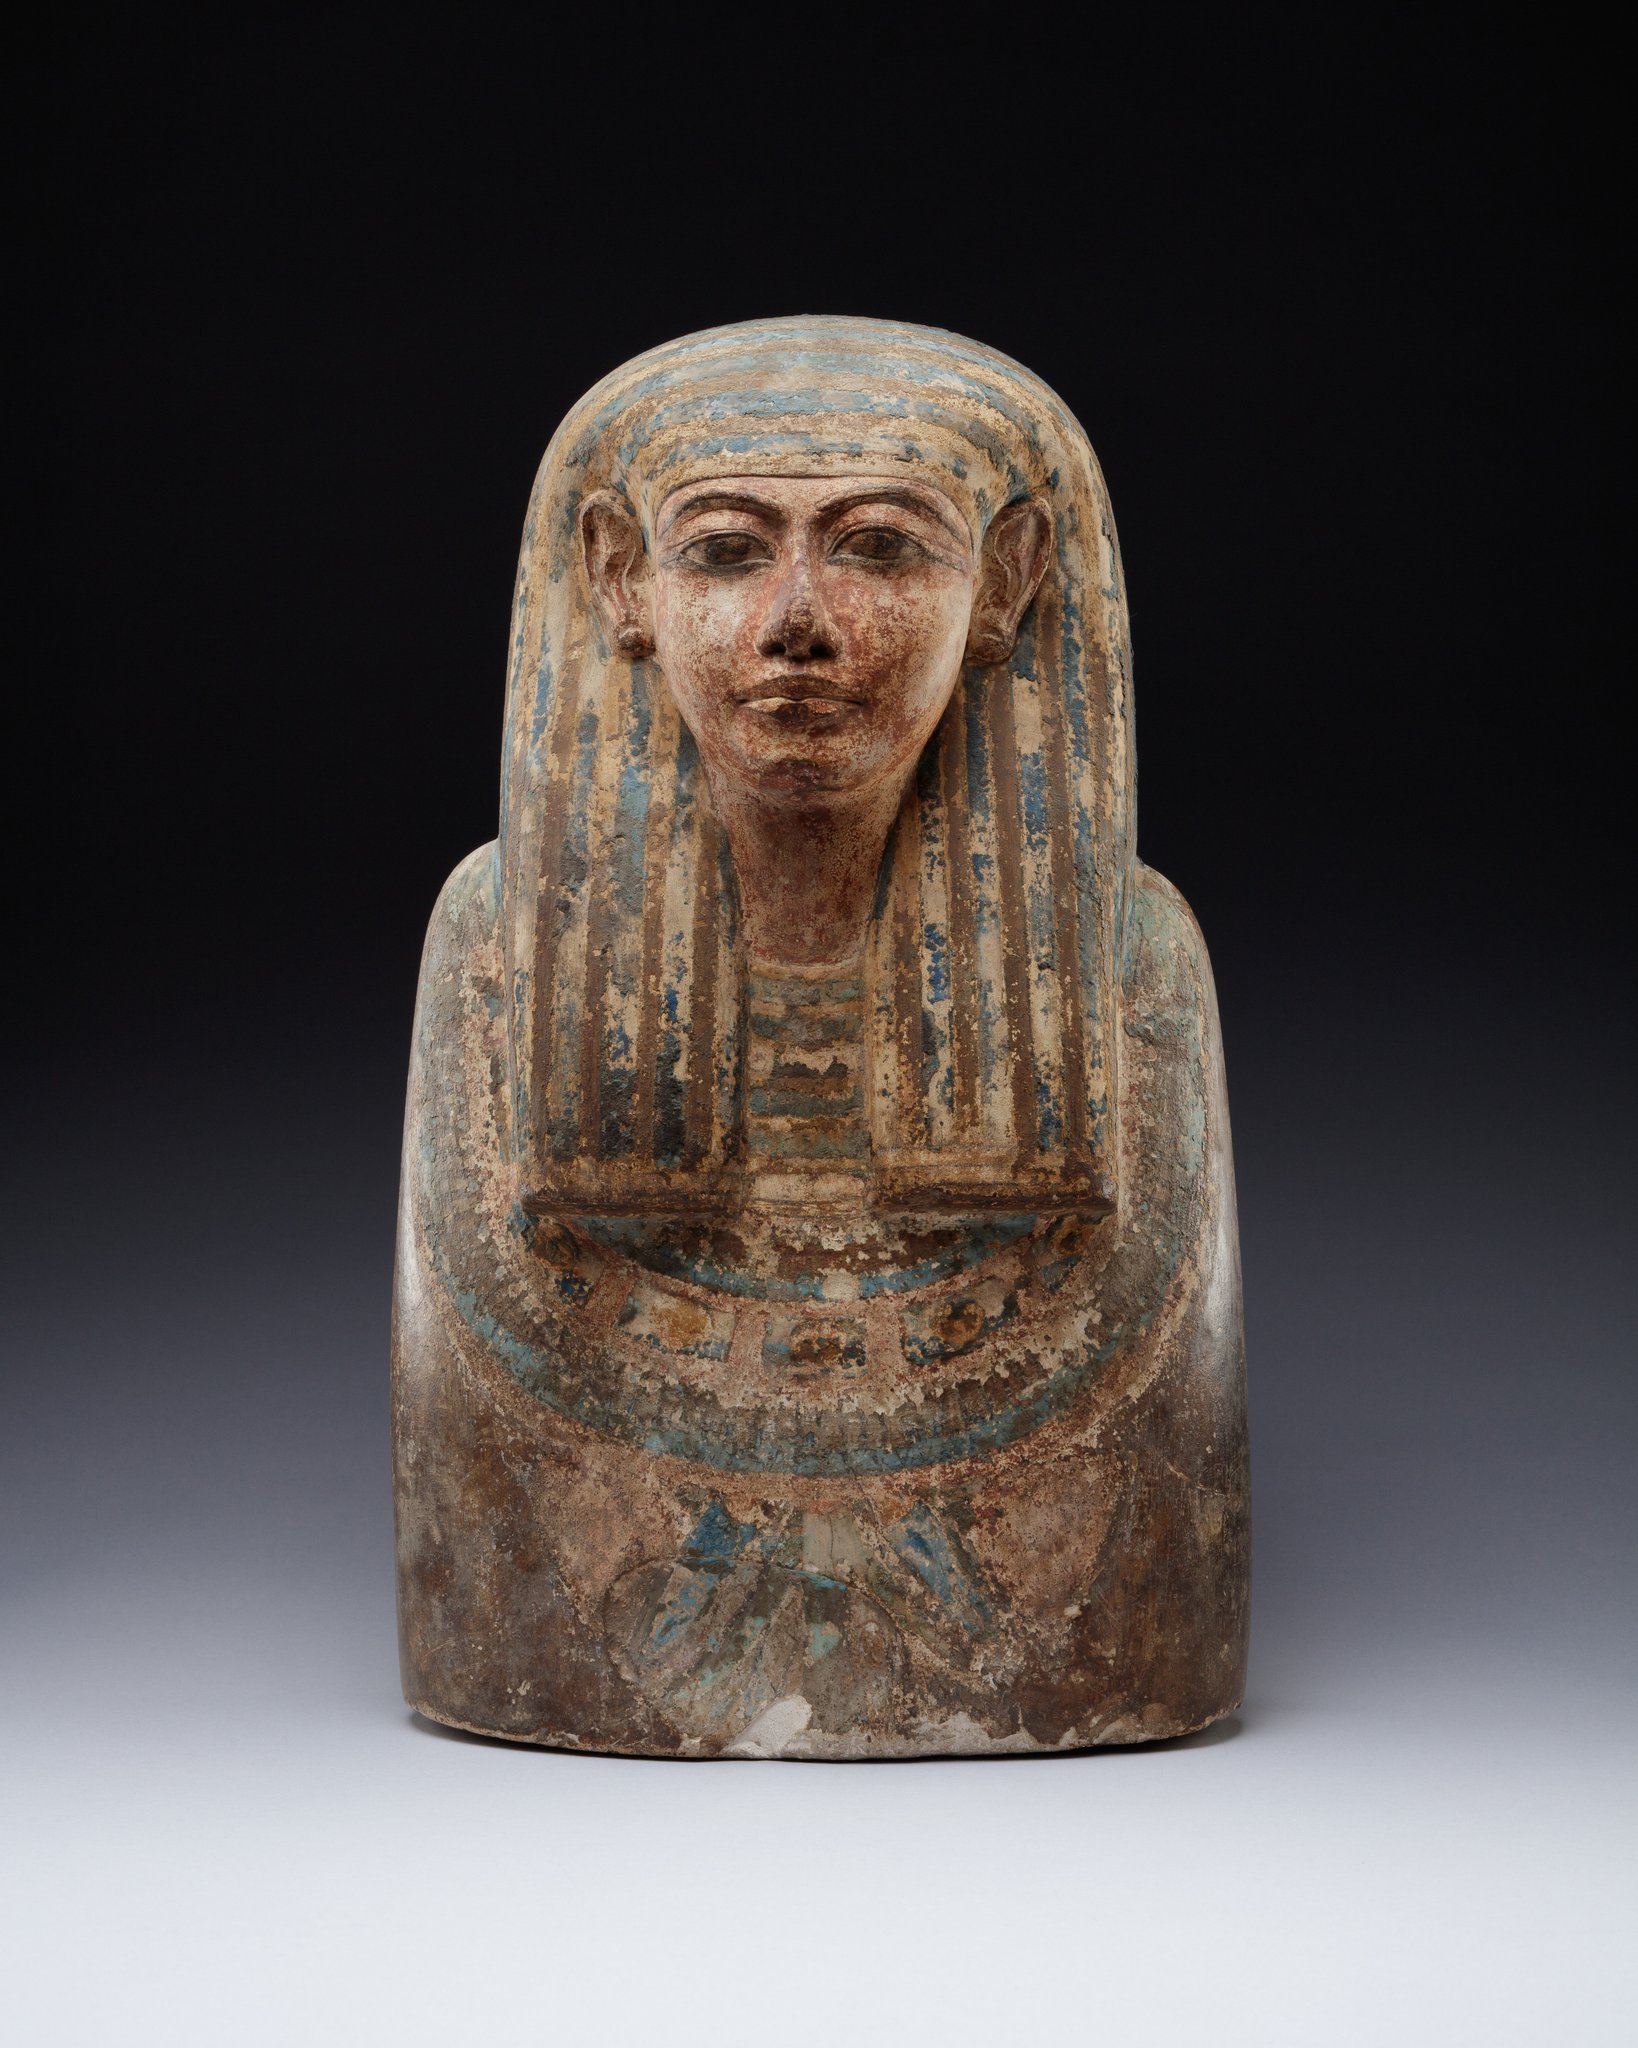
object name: bust, ancestral, ancestor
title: Bust of a Revered Person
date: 1320-1237 BCE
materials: limestone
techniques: painting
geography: egypt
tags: portraits